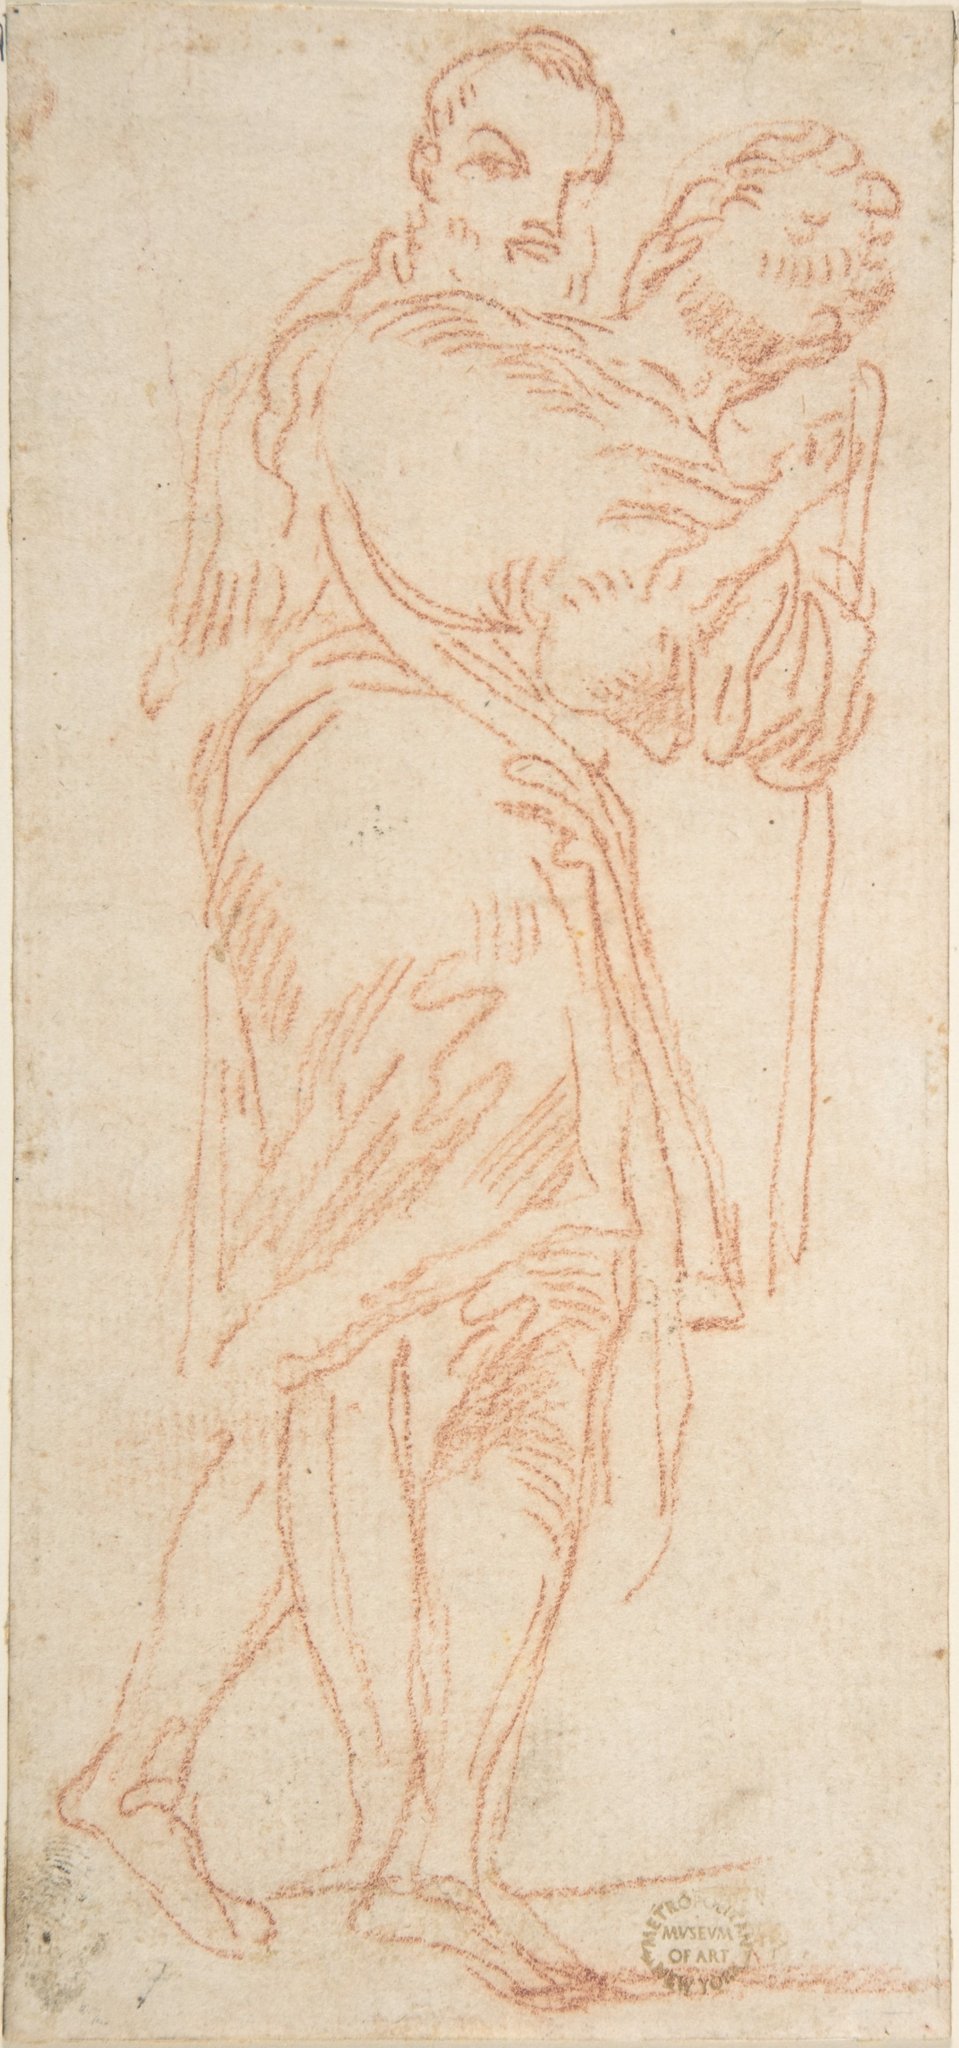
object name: drawing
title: Two Standing Men, One Carrying a Lamb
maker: anonymous, italian, roman-bolognese, 17th century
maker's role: artist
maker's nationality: italian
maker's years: 1600-1700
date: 1601-1700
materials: chalk, paper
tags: men,lambs